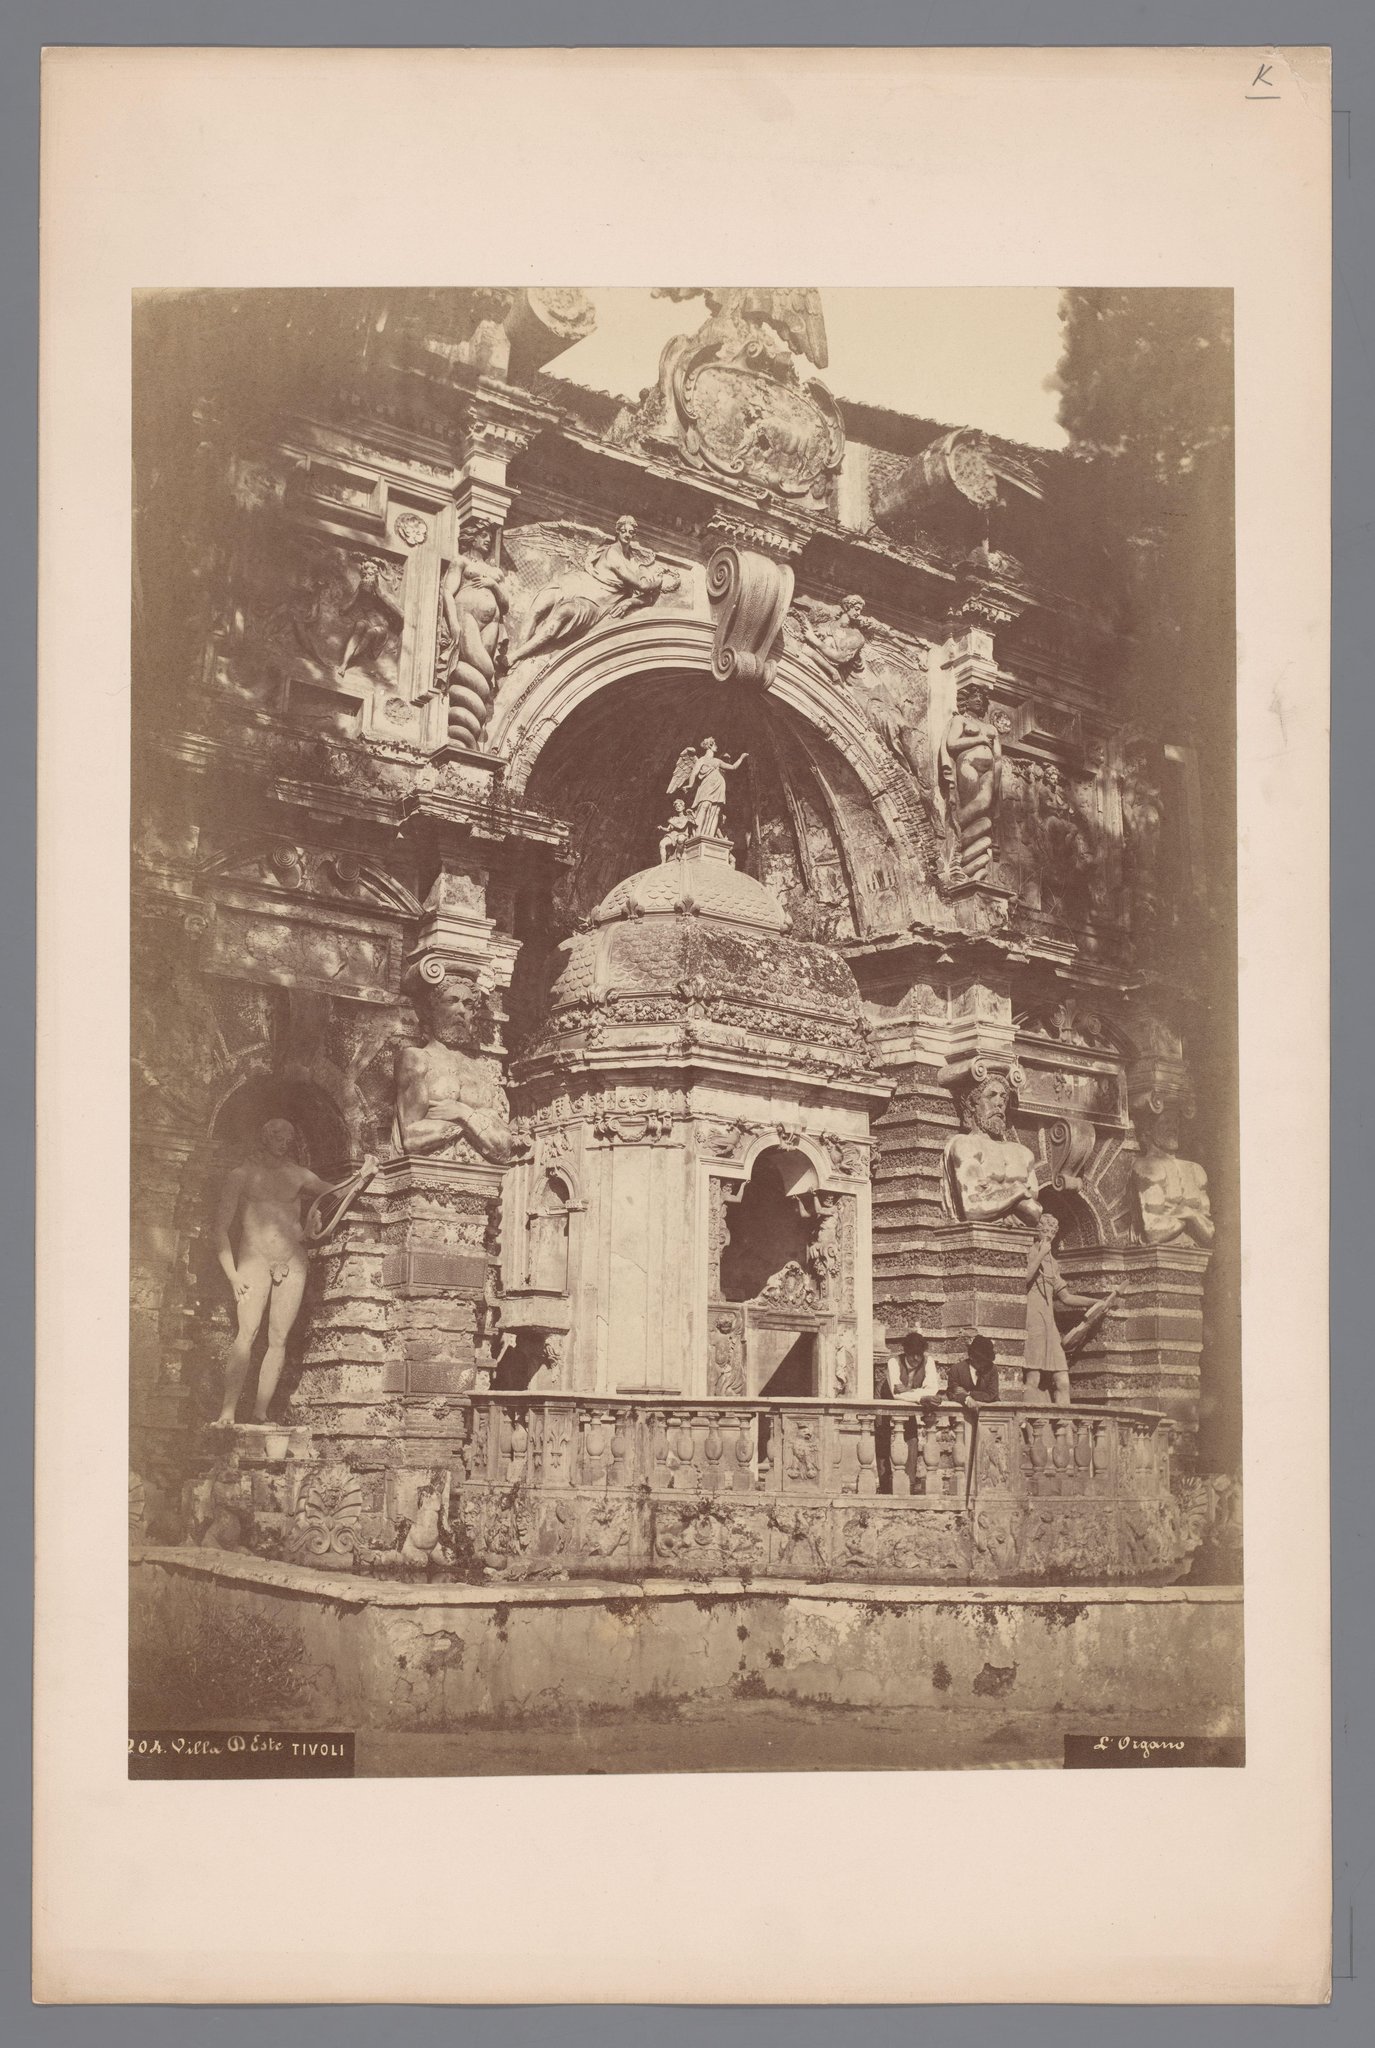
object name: photograph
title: Twee mannen leunend over de balustrade in de Villa d'Este te Tivoli, Italië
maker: Anonymous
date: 1851-1900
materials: cardboard, paper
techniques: albumen print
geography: tivoli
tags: palace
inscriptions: inscription: ‘K’, inscription: ‘L'Organo’, number: ‘20A’